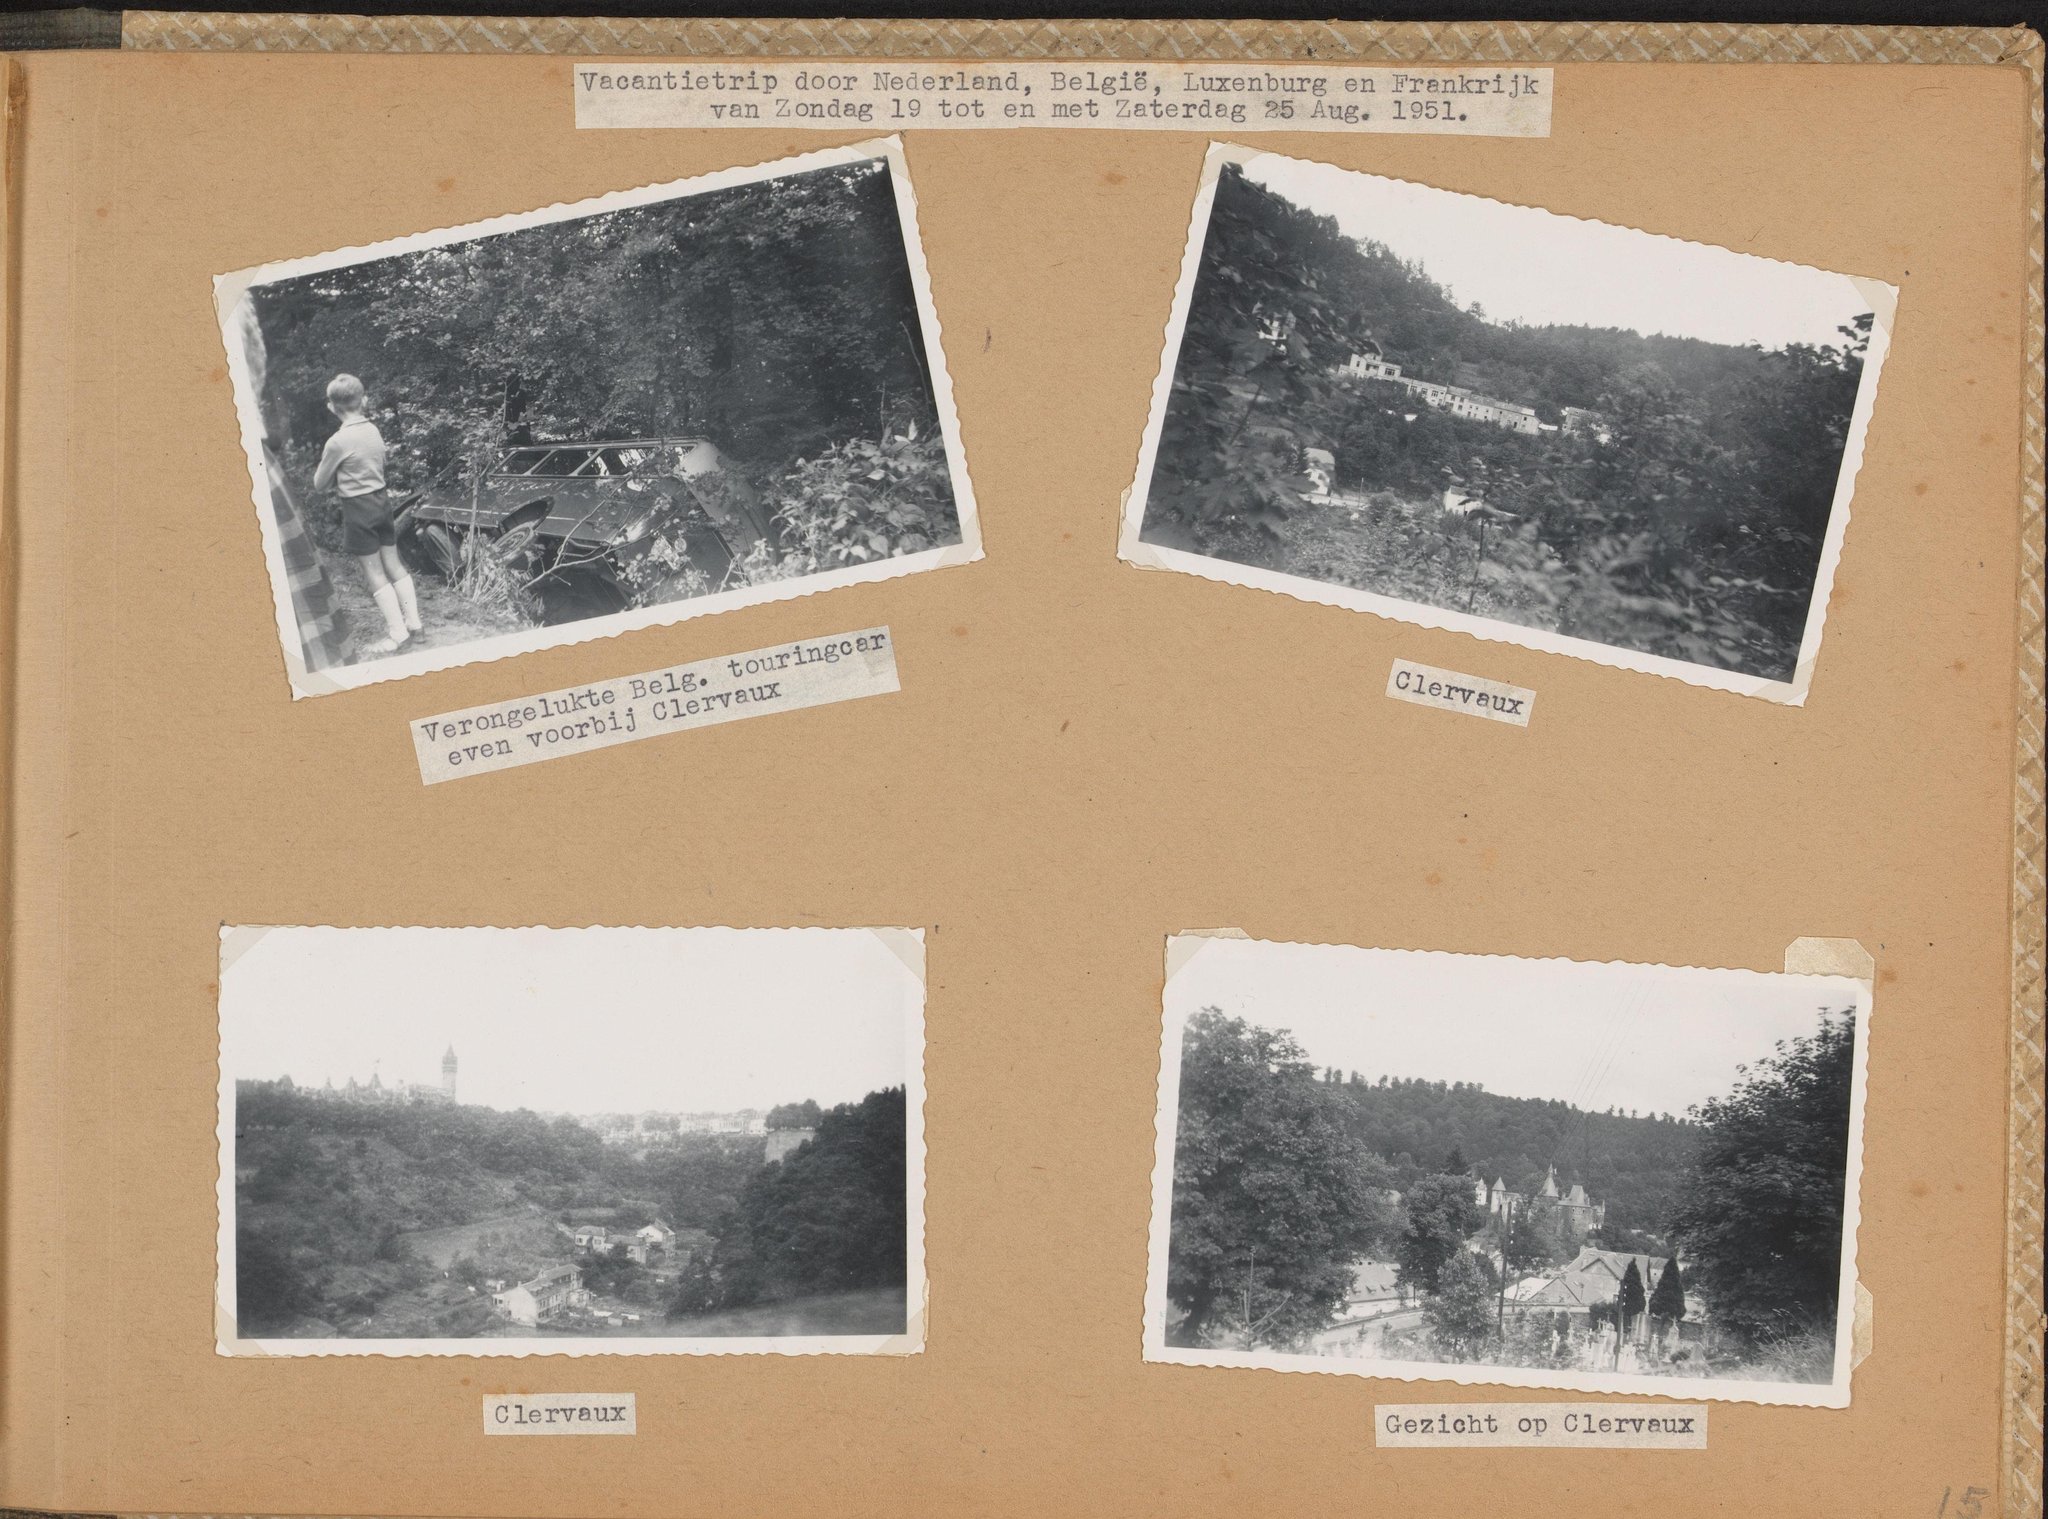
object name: album leaf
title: Clervaux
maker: Anonymous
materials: paper, photographic support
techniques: gelatin silver print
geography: clervaux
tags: the family travelling, on holiday, bus, coach (+ accident, collision, crash ~traffic and transport), outing, pleasure trip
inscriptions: inscription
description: Albumblad met vier foto's met gezichten van Clervaux in Luxemburg. Onder de foto's uitgeknipte papiertjes met getypte opschriften. Onderdeel van het tweede fotoalbum met foto's van familievakanties in Nederland, België, Luxemburg en Frankrijk in 1950-1951.